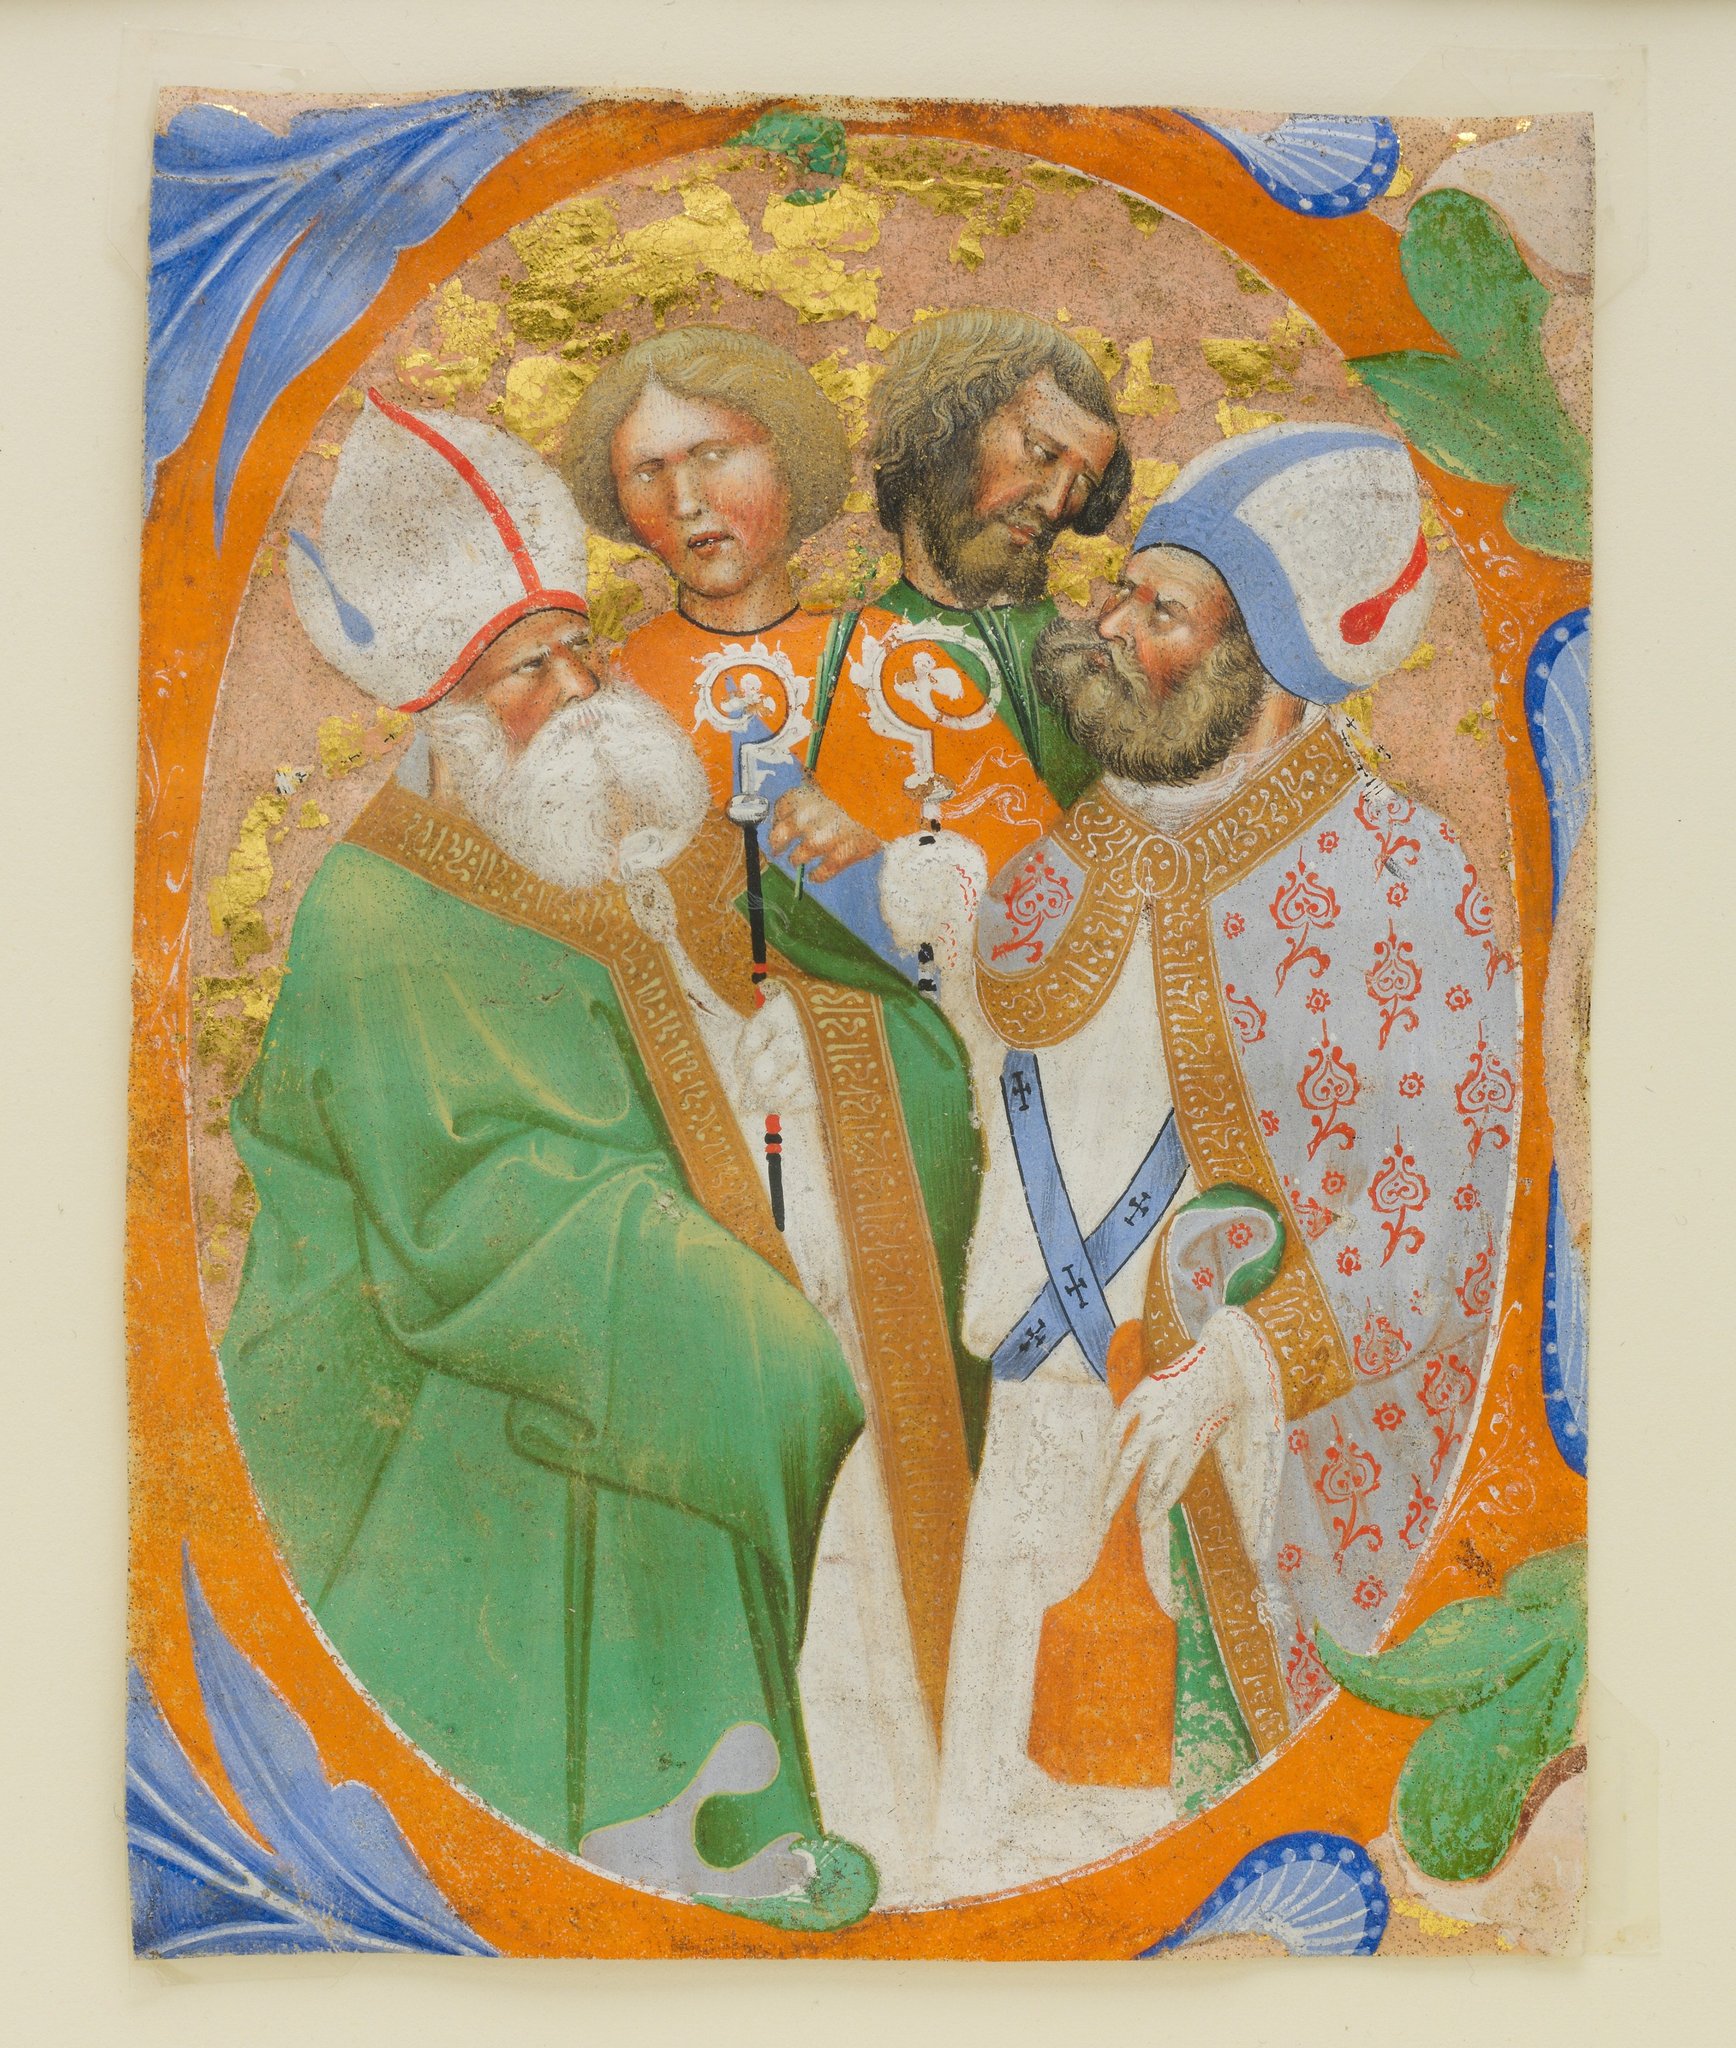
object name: choir book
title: Manuscript Illumination with Four Saints in an Initial O, from a Choir Book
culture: italian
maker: master of the murano gradual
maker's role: artist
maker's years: 1430-1460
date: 1440-1450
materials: gold, ink, parchment, paint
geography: italy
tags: men,saints